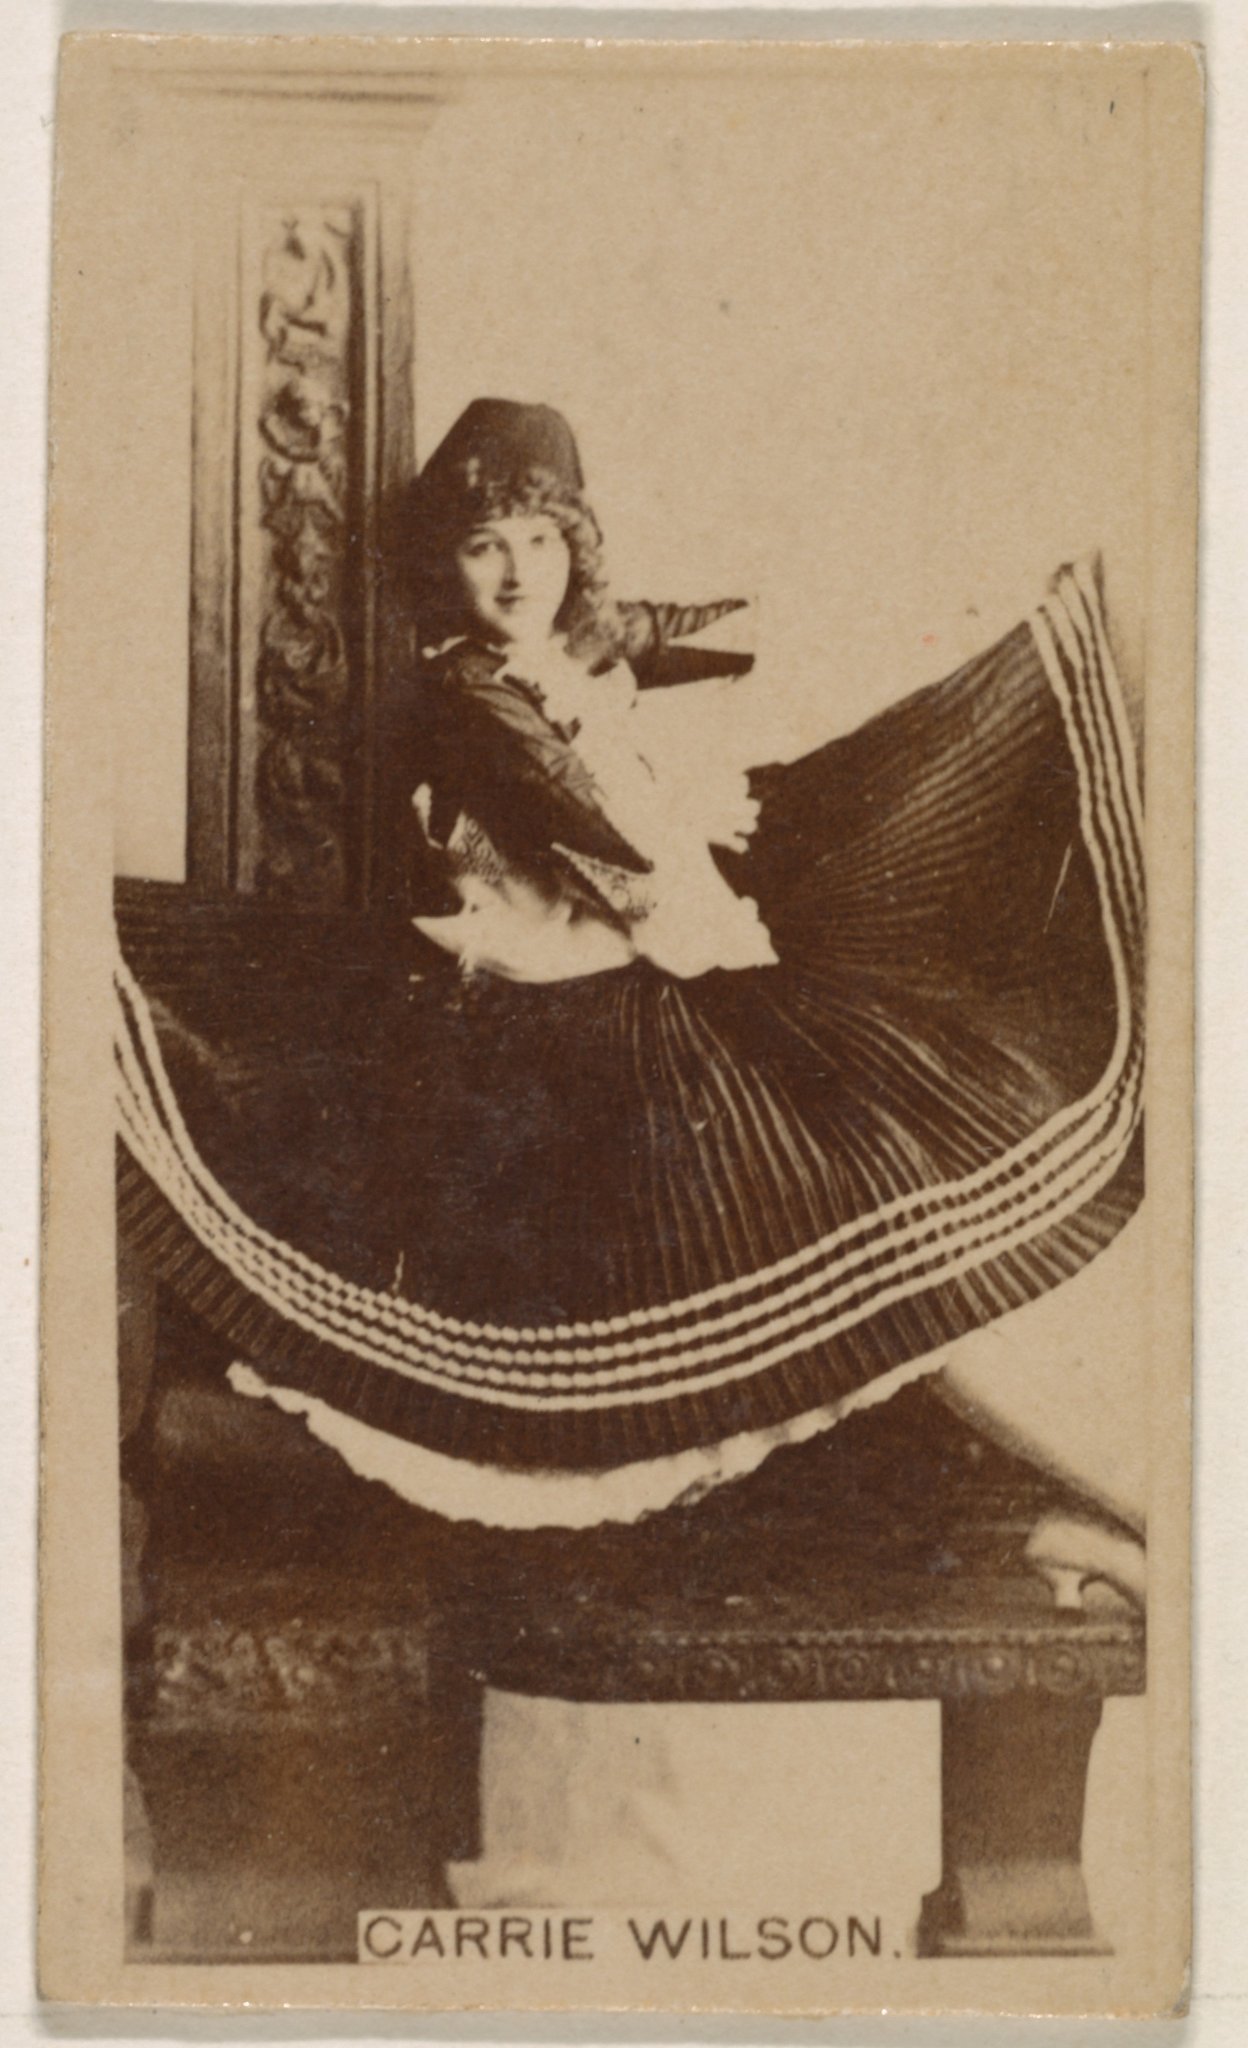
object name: photograph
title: Carrie Wilson, from the Actresses series (N245) issued by Kinney Brothers to promote Sweet Caporal Cigarettes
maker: kinney brothers tobacco company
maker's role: publisher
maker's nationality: american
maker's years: 1869-2011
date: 1890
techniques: albumen silver print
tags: portraits,women,actresses